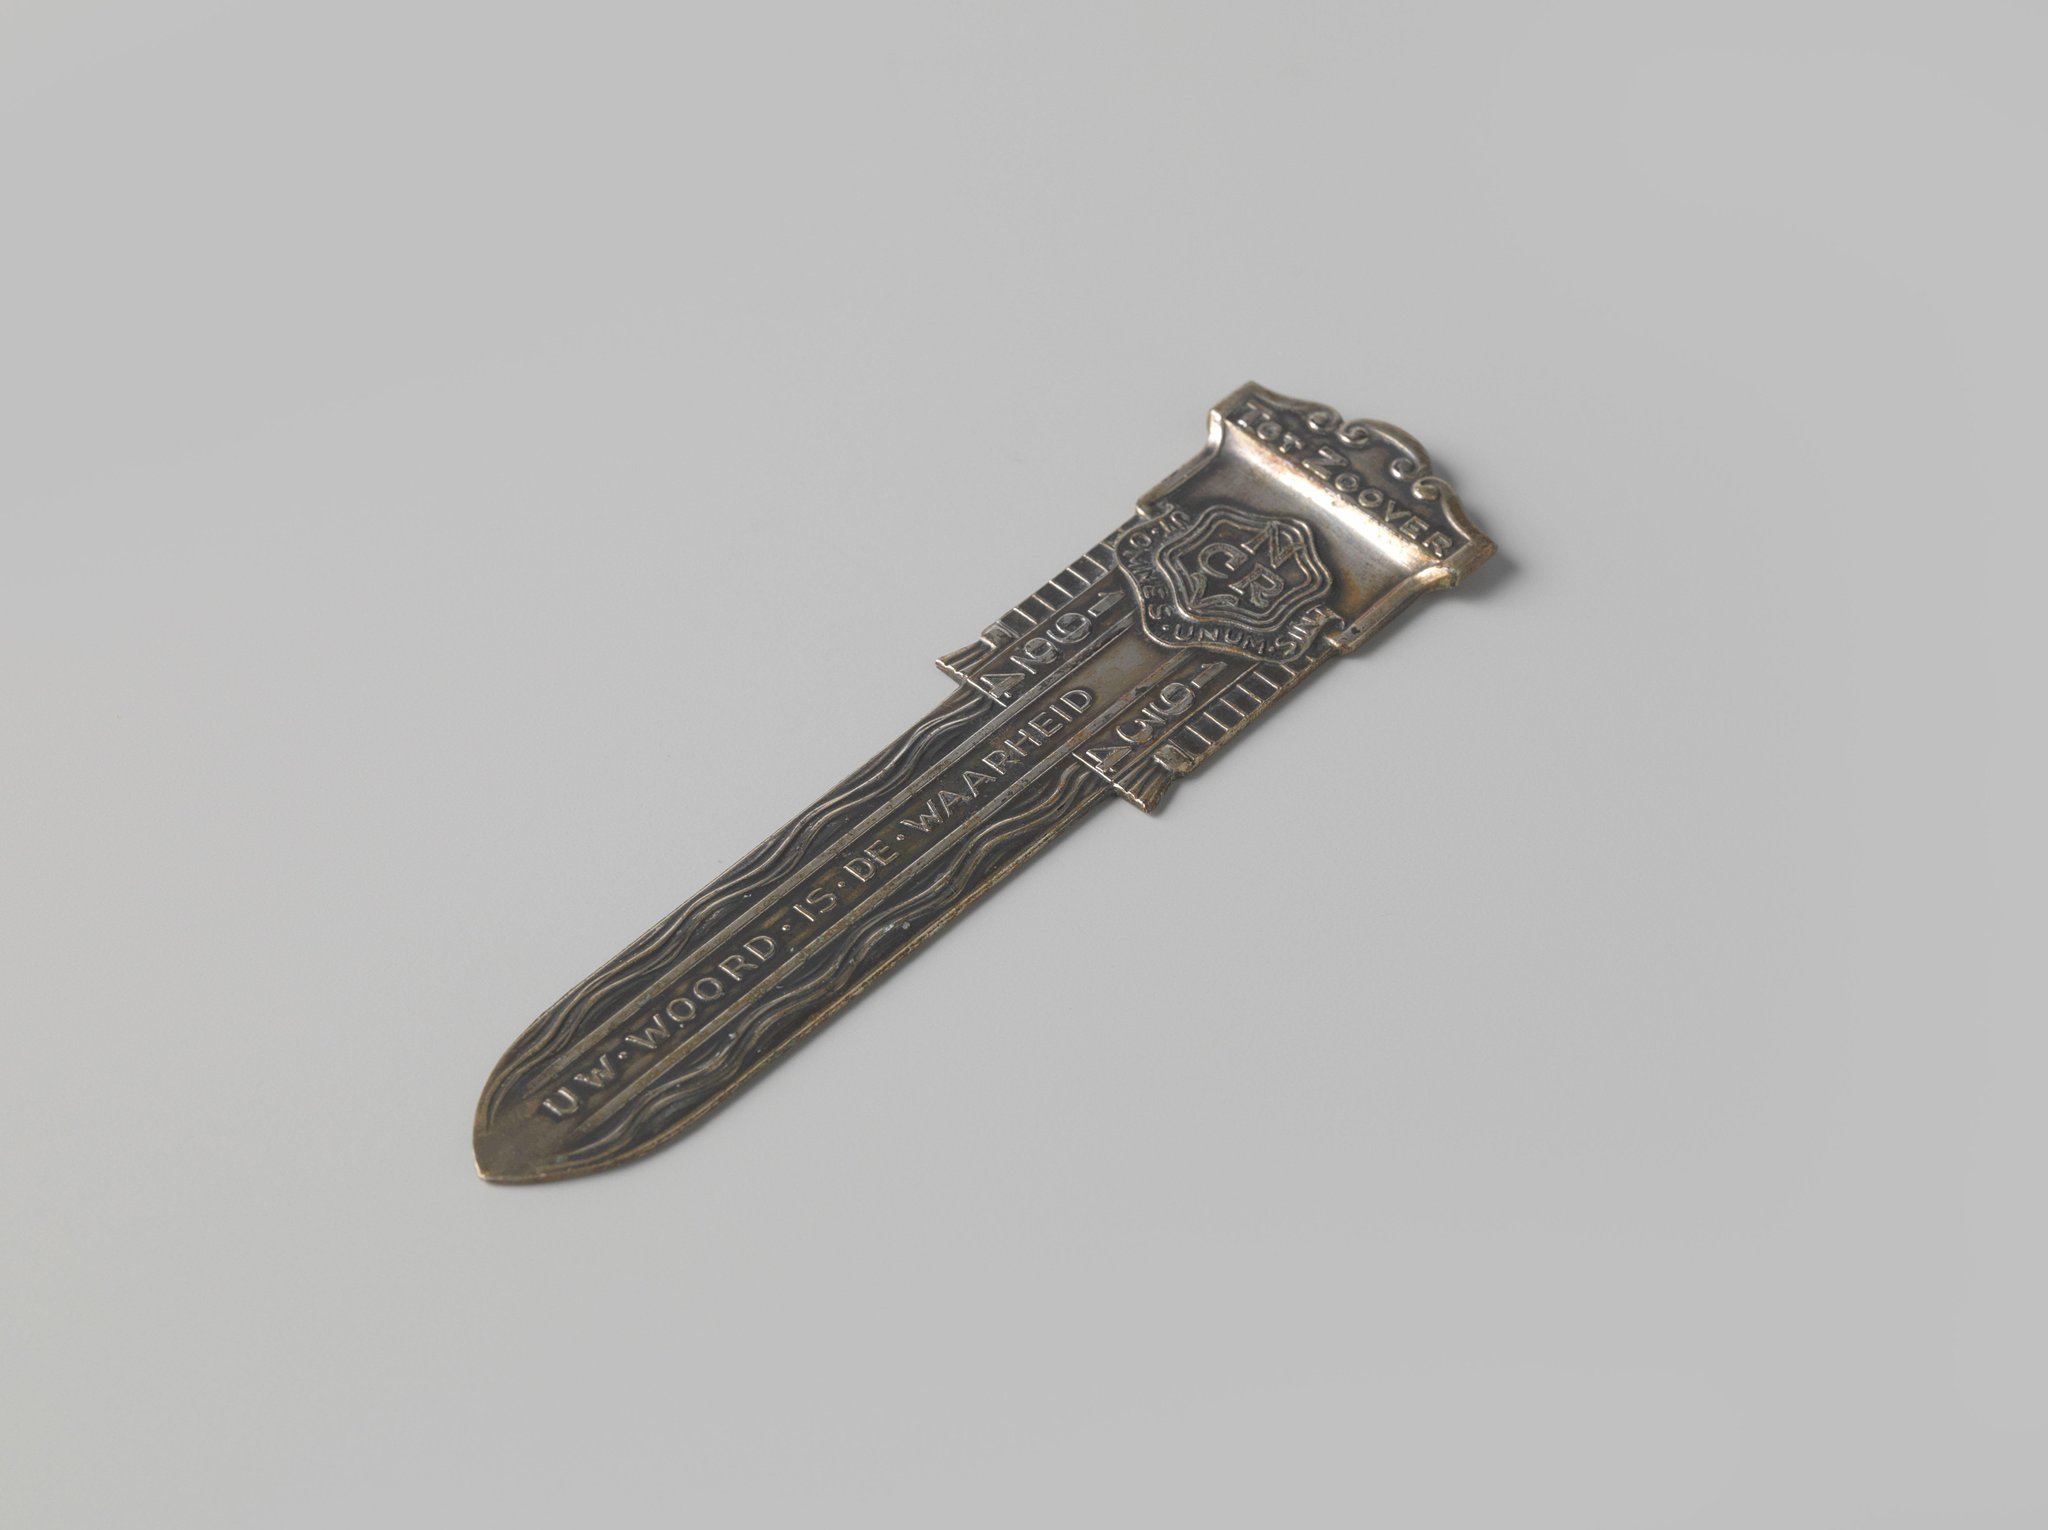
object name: letter opener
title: Briefopener van het 10-jarig jubilieum van de Nederlandse Christelijke Radio Vereeniging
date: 1924-1934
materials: metal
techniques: silvering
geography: zeist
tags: netherlands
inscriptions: : ‘TOT ZOOVER NCRV UT OMNES UNUM SINT 1942-1943 UW WOORD IS DE WAARHEID’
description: Boekenlegger met rechthoekig bovendeel met aan de bovenzijde een lofje. Snijvlak springt in en loopt uit in een punt. De briefopener draagt verschillende opschriften, het embleem met de afgeronde zeshoek en de letters N / CR / V en de datering. Op de keerzijde 3 merken en het embleem van de NCRV.